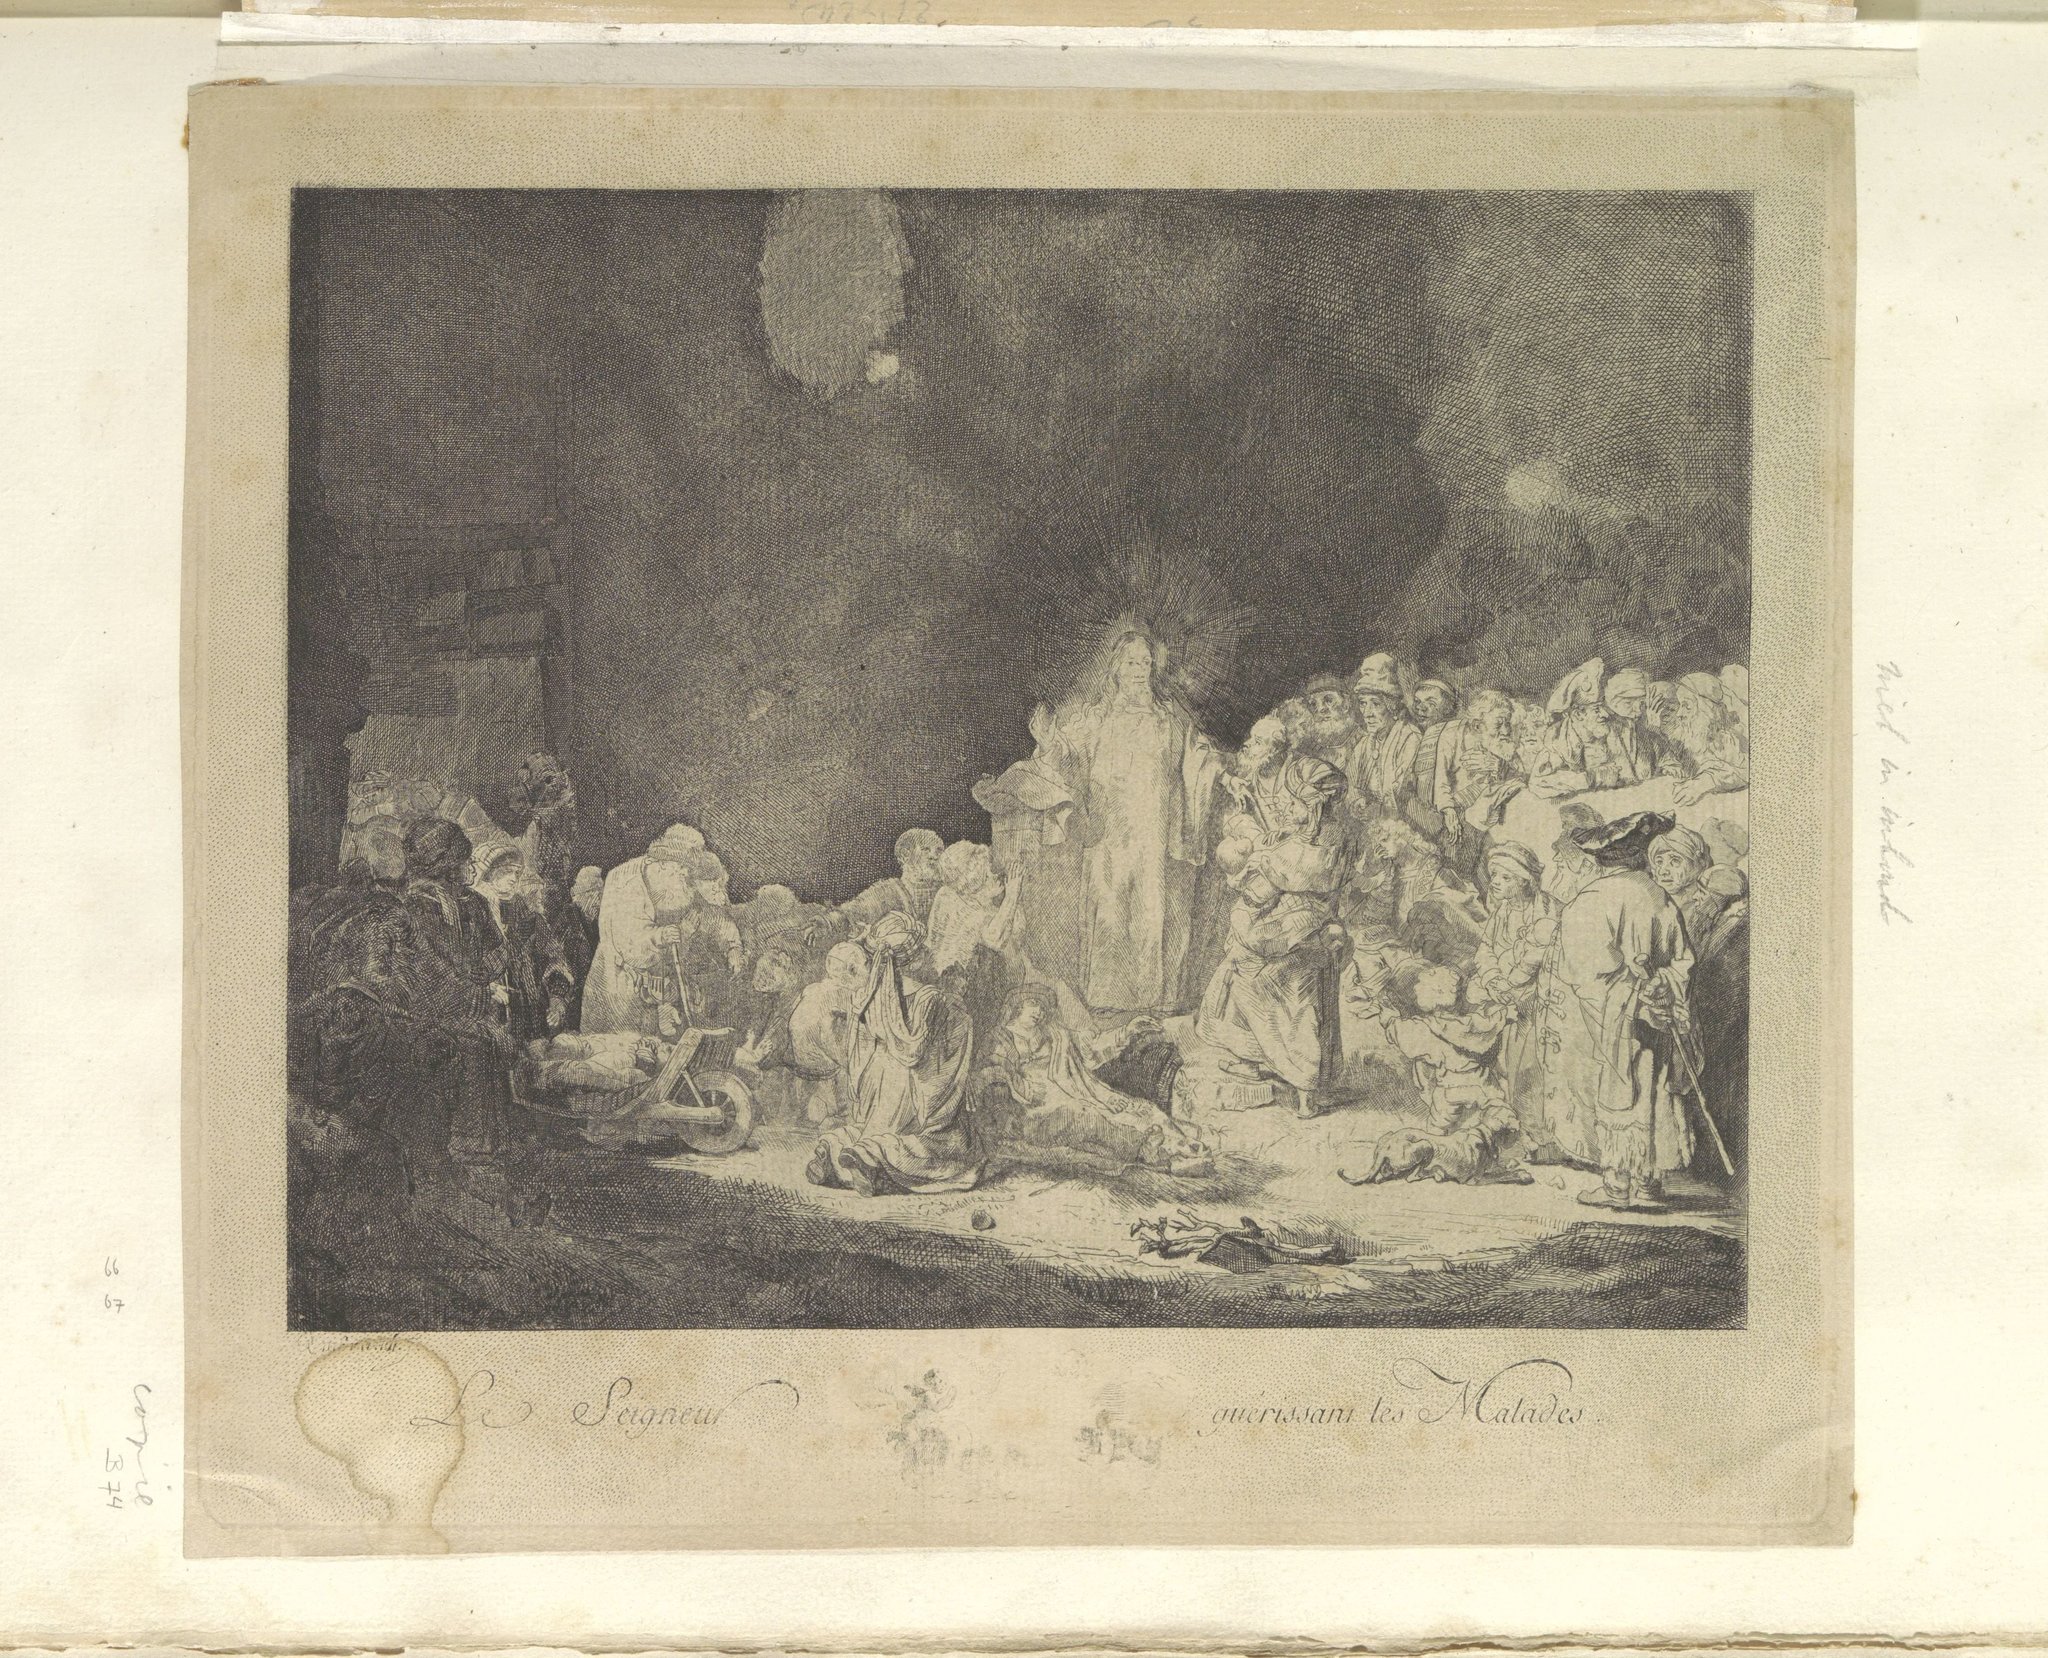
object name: album leaf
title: Le Seigneur guérissant les Malades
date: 1717-1783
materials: paper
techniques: etching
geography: paris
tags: christ preaching or teaching (in general)